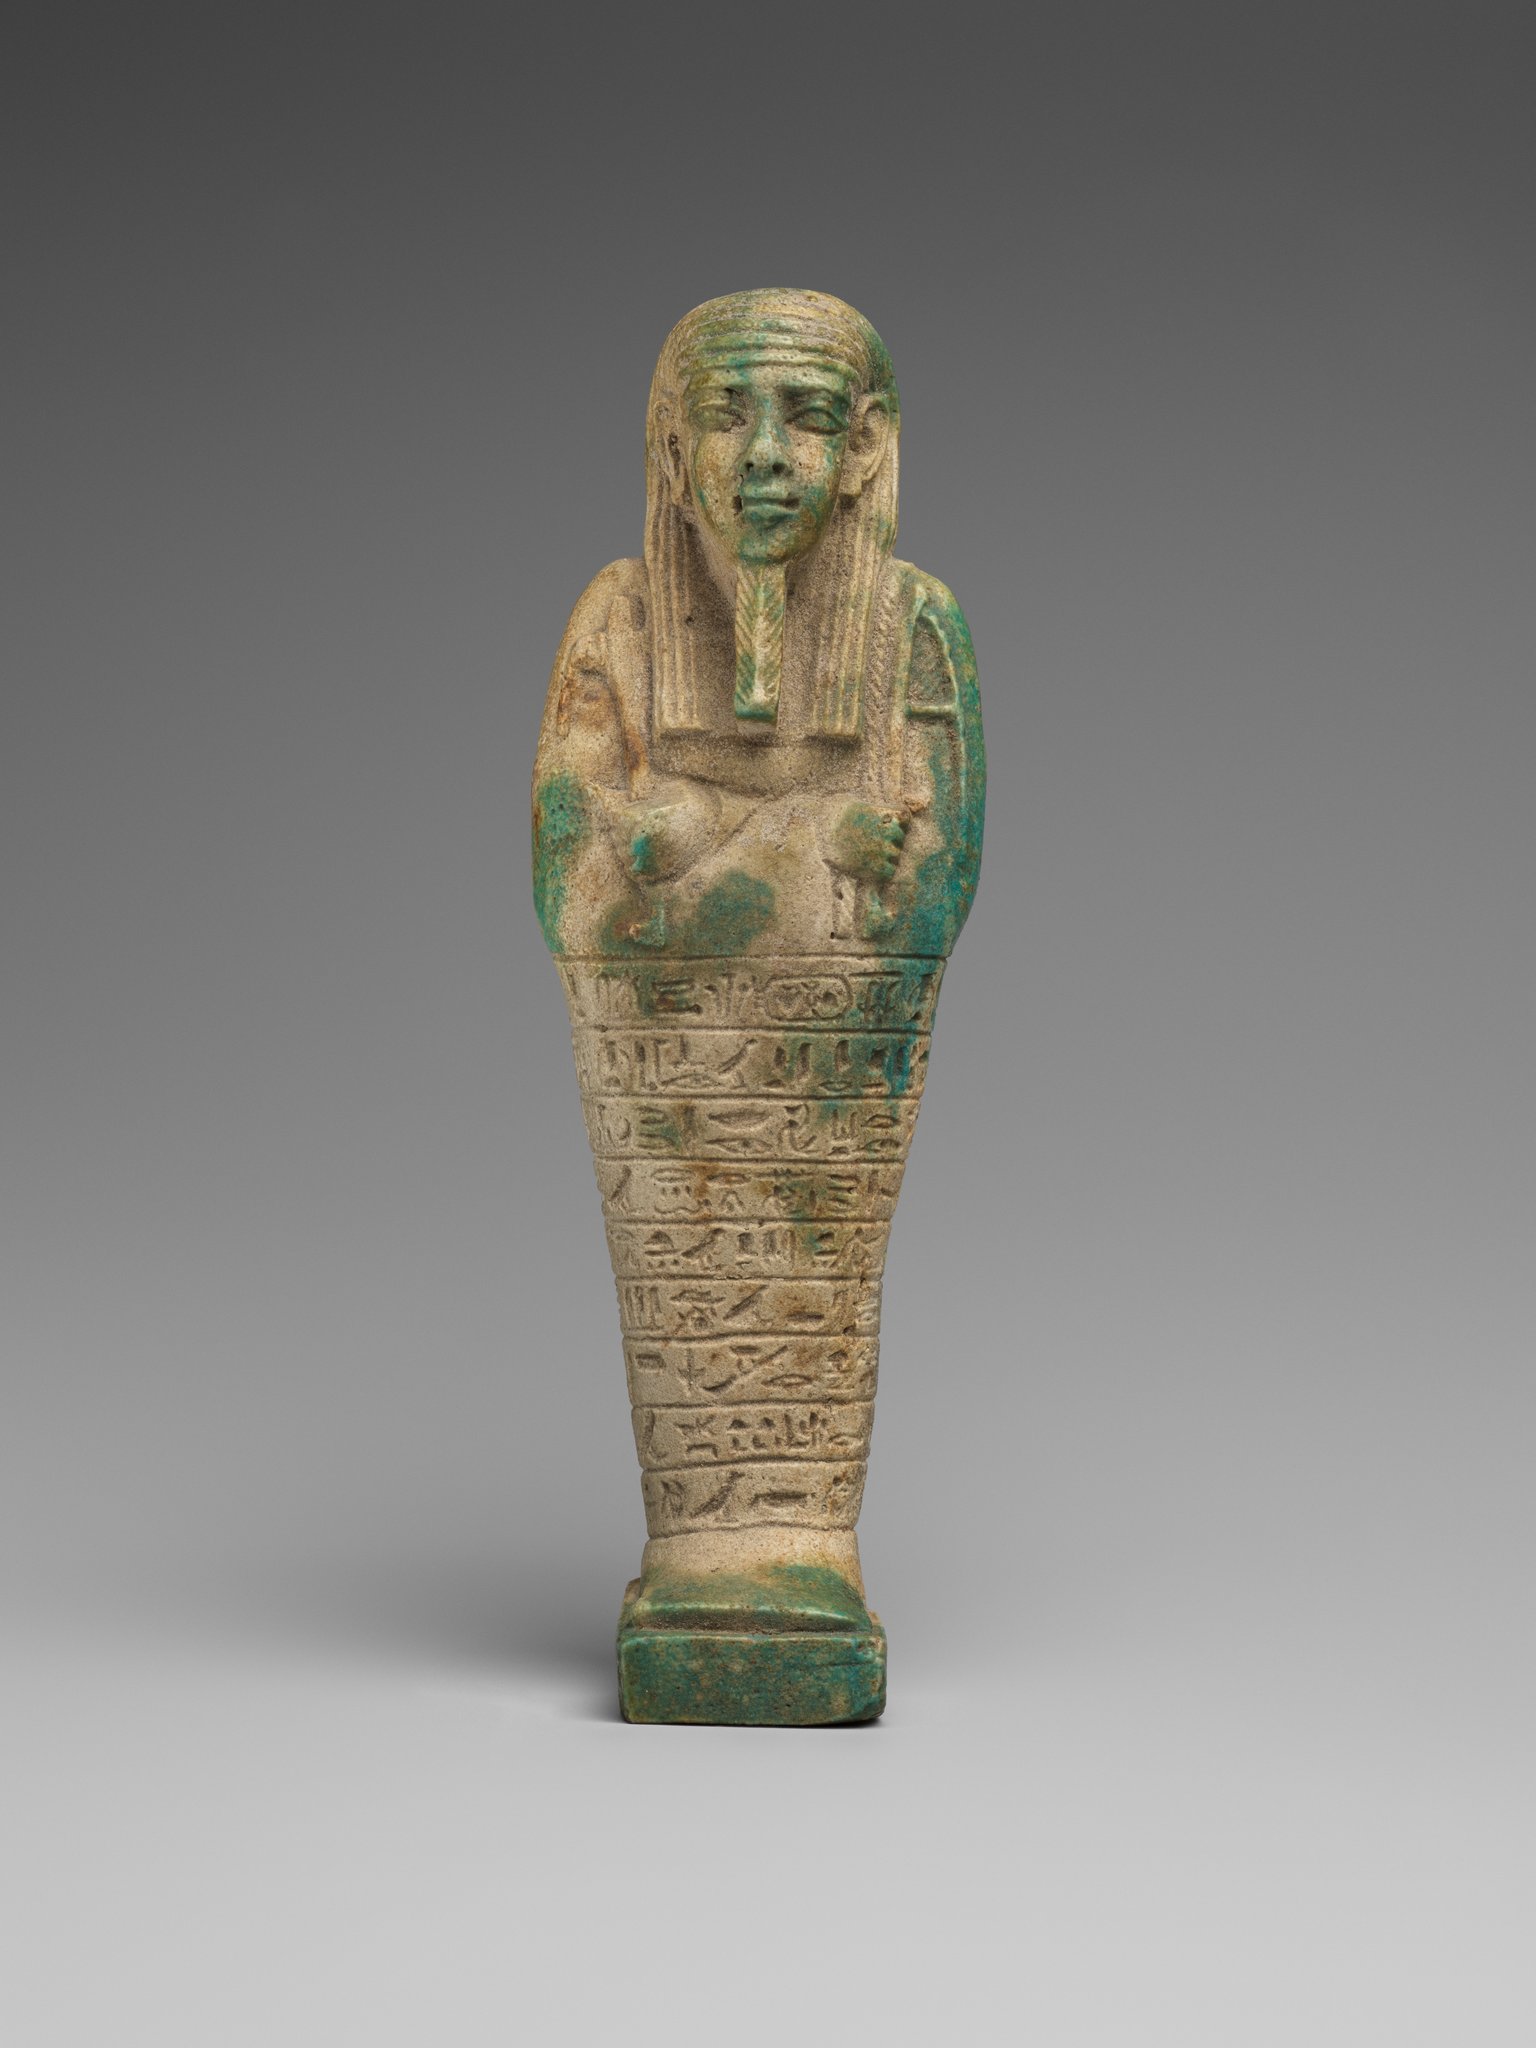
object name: shabti, wahibremhebyt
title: Shabti of Wahibremhebyt, son of Isetweret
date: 570-526 BCE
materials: faience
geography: egypt